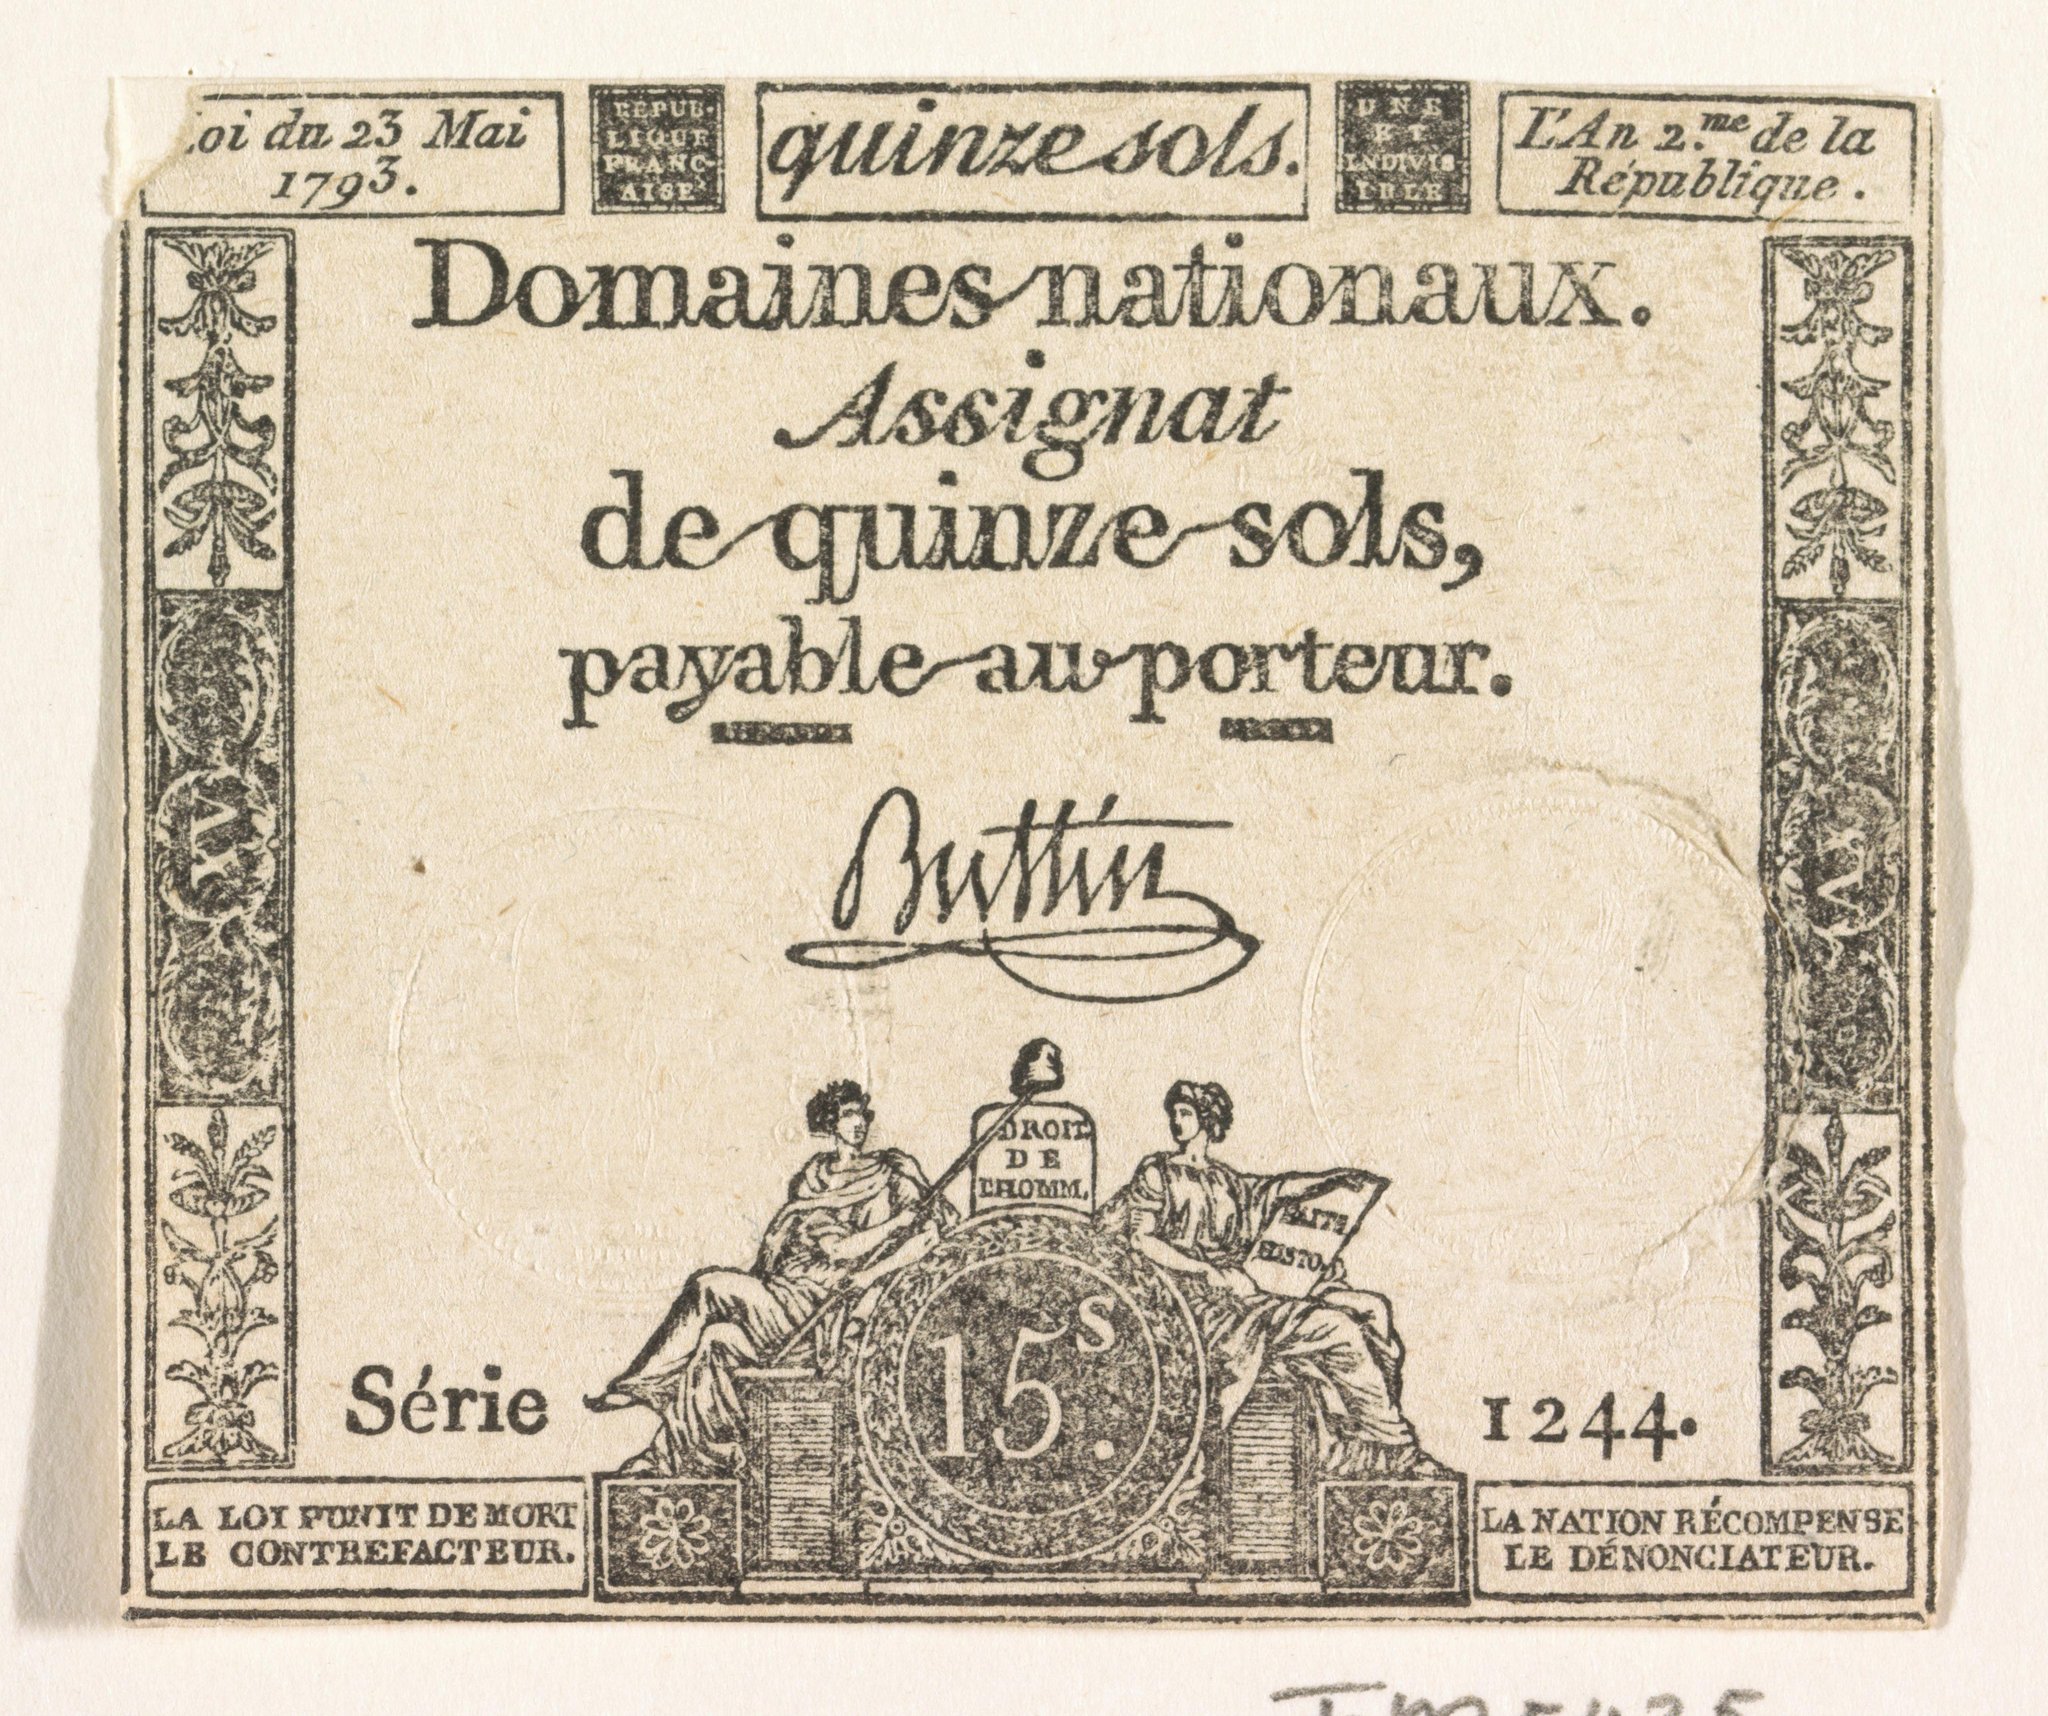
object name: assignat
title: Assignat de quinze sols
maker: Anonymous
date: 1793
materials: paper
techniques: blind stamped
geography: france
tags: bank-note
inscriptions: collector's mark: Lugt 2228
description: Franse assignaat ter waarde van vijftien sols. In omloop gebracht door de Domaines nationaux, serie 1244, volgens de wet van 23 mei 1793.